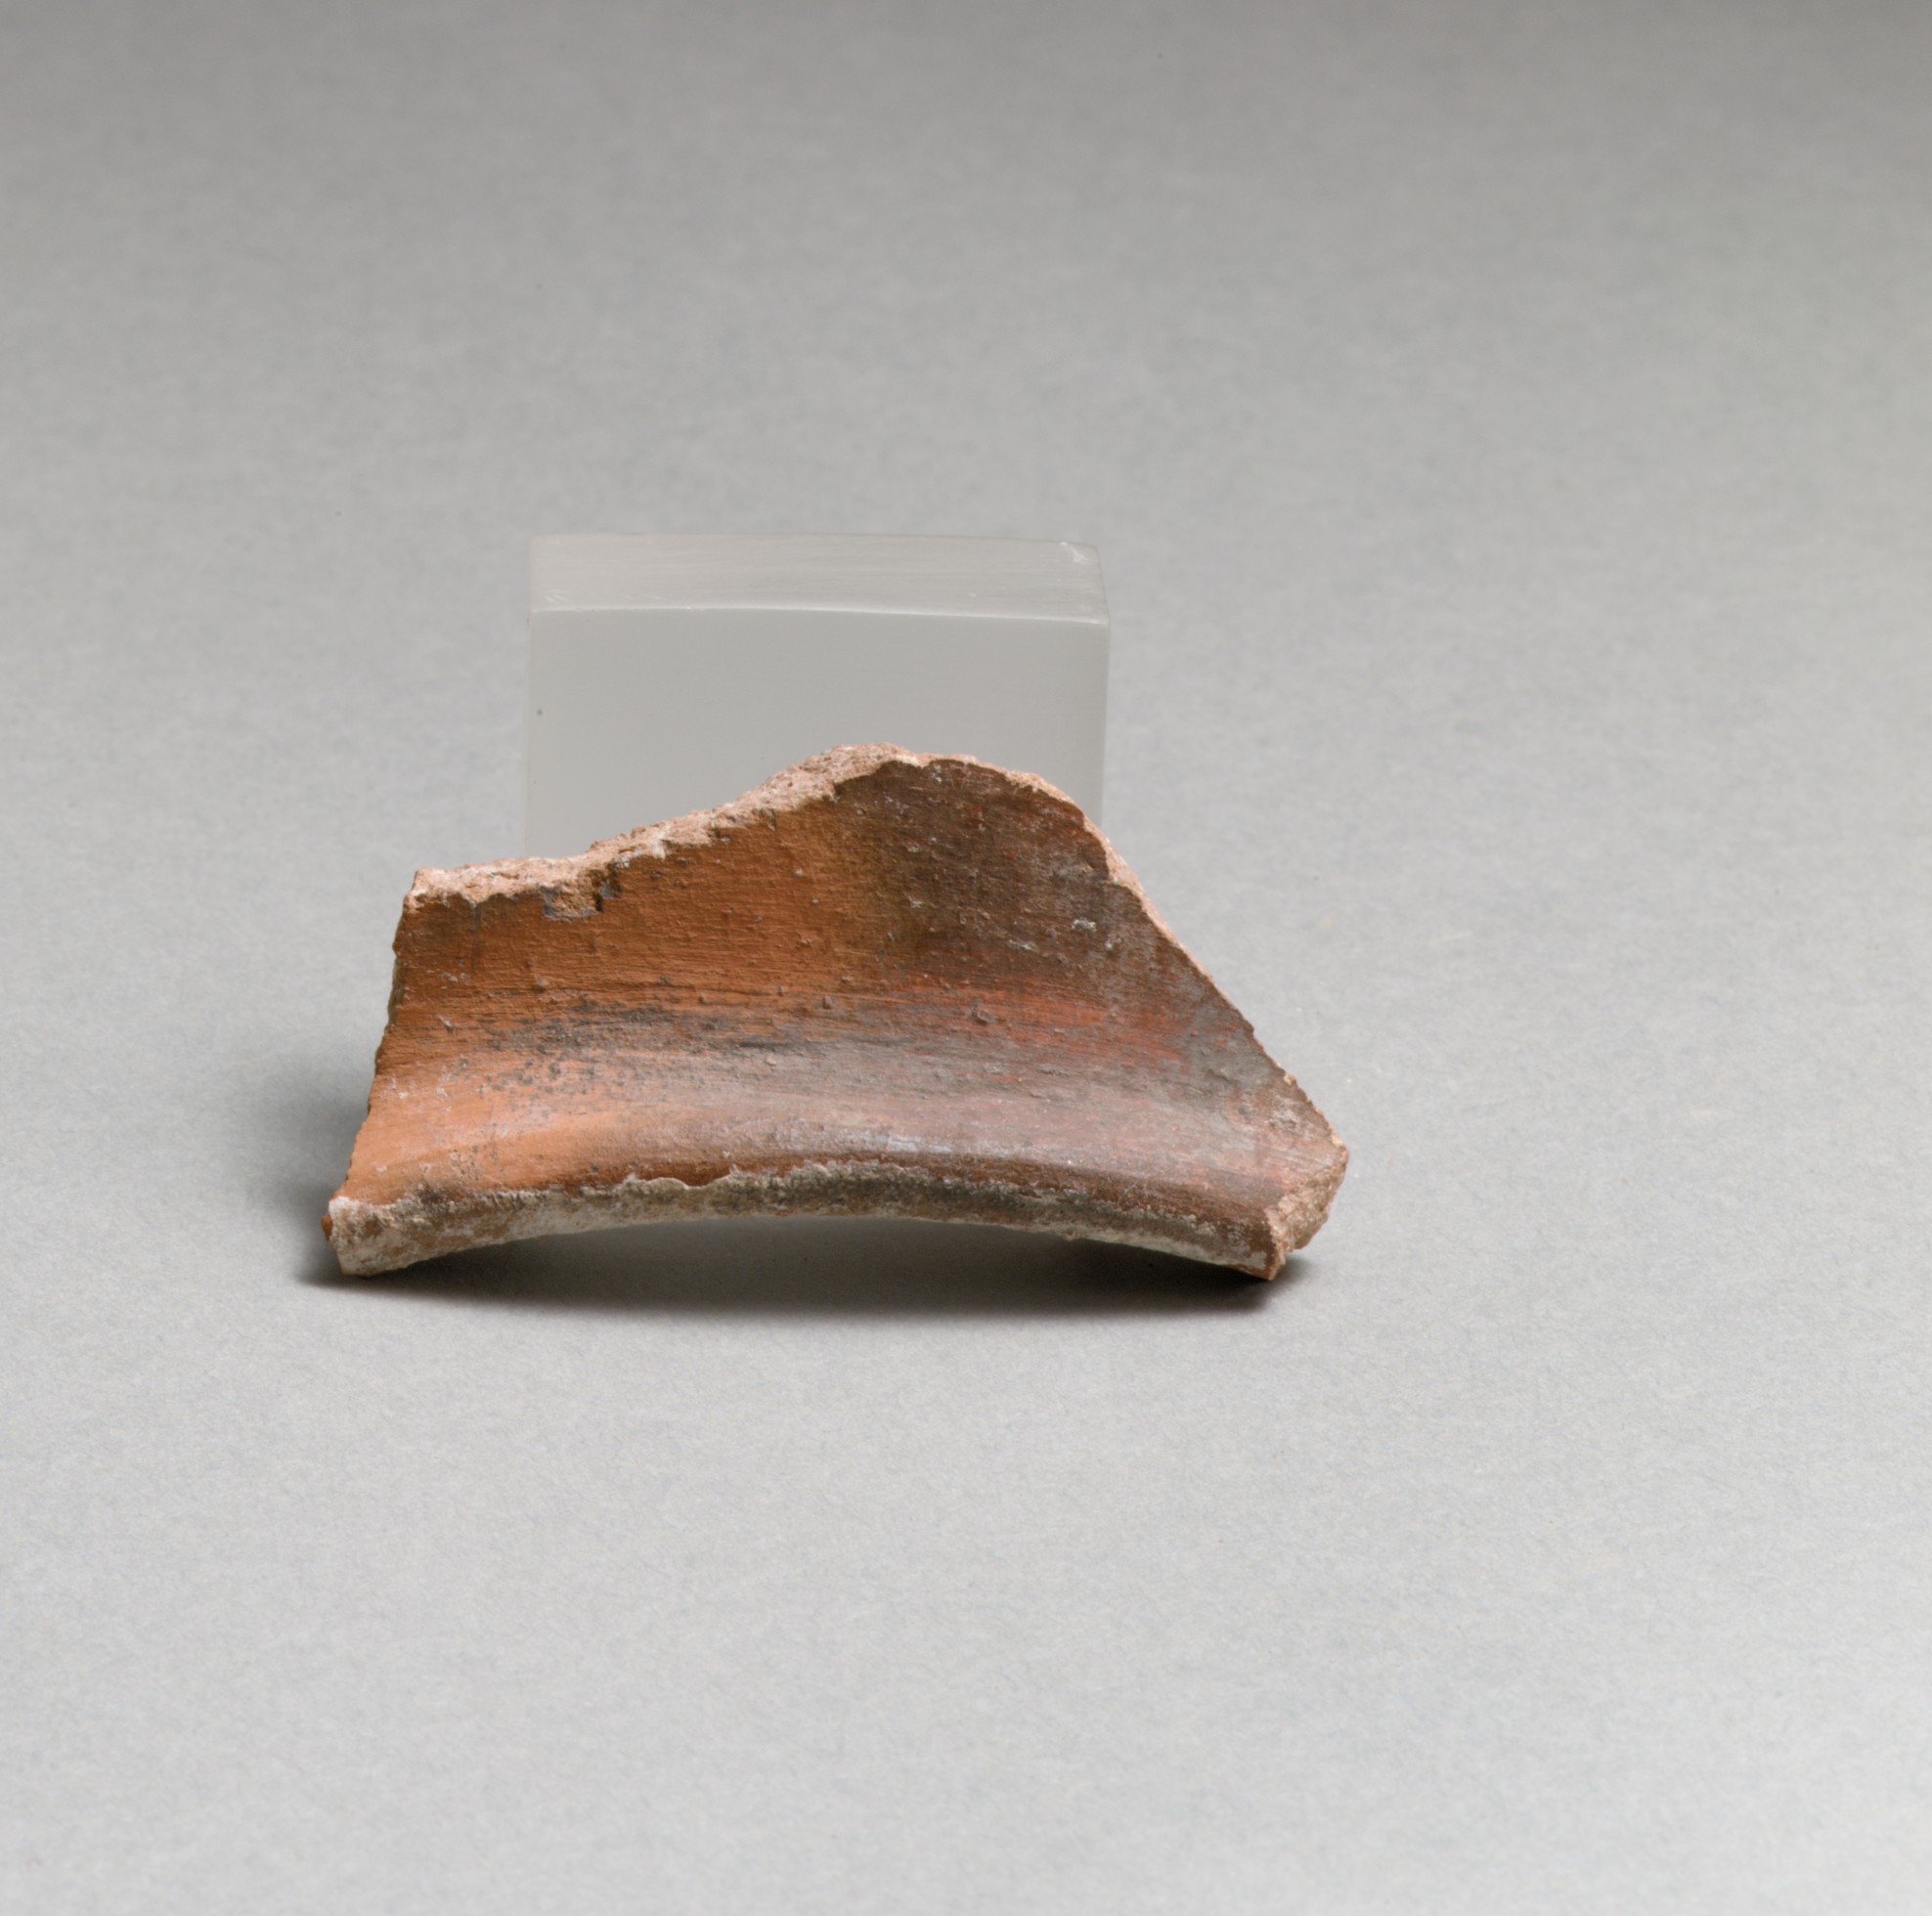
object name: vase fragment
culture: minoan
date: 2600-2000 BCE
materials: terracotta